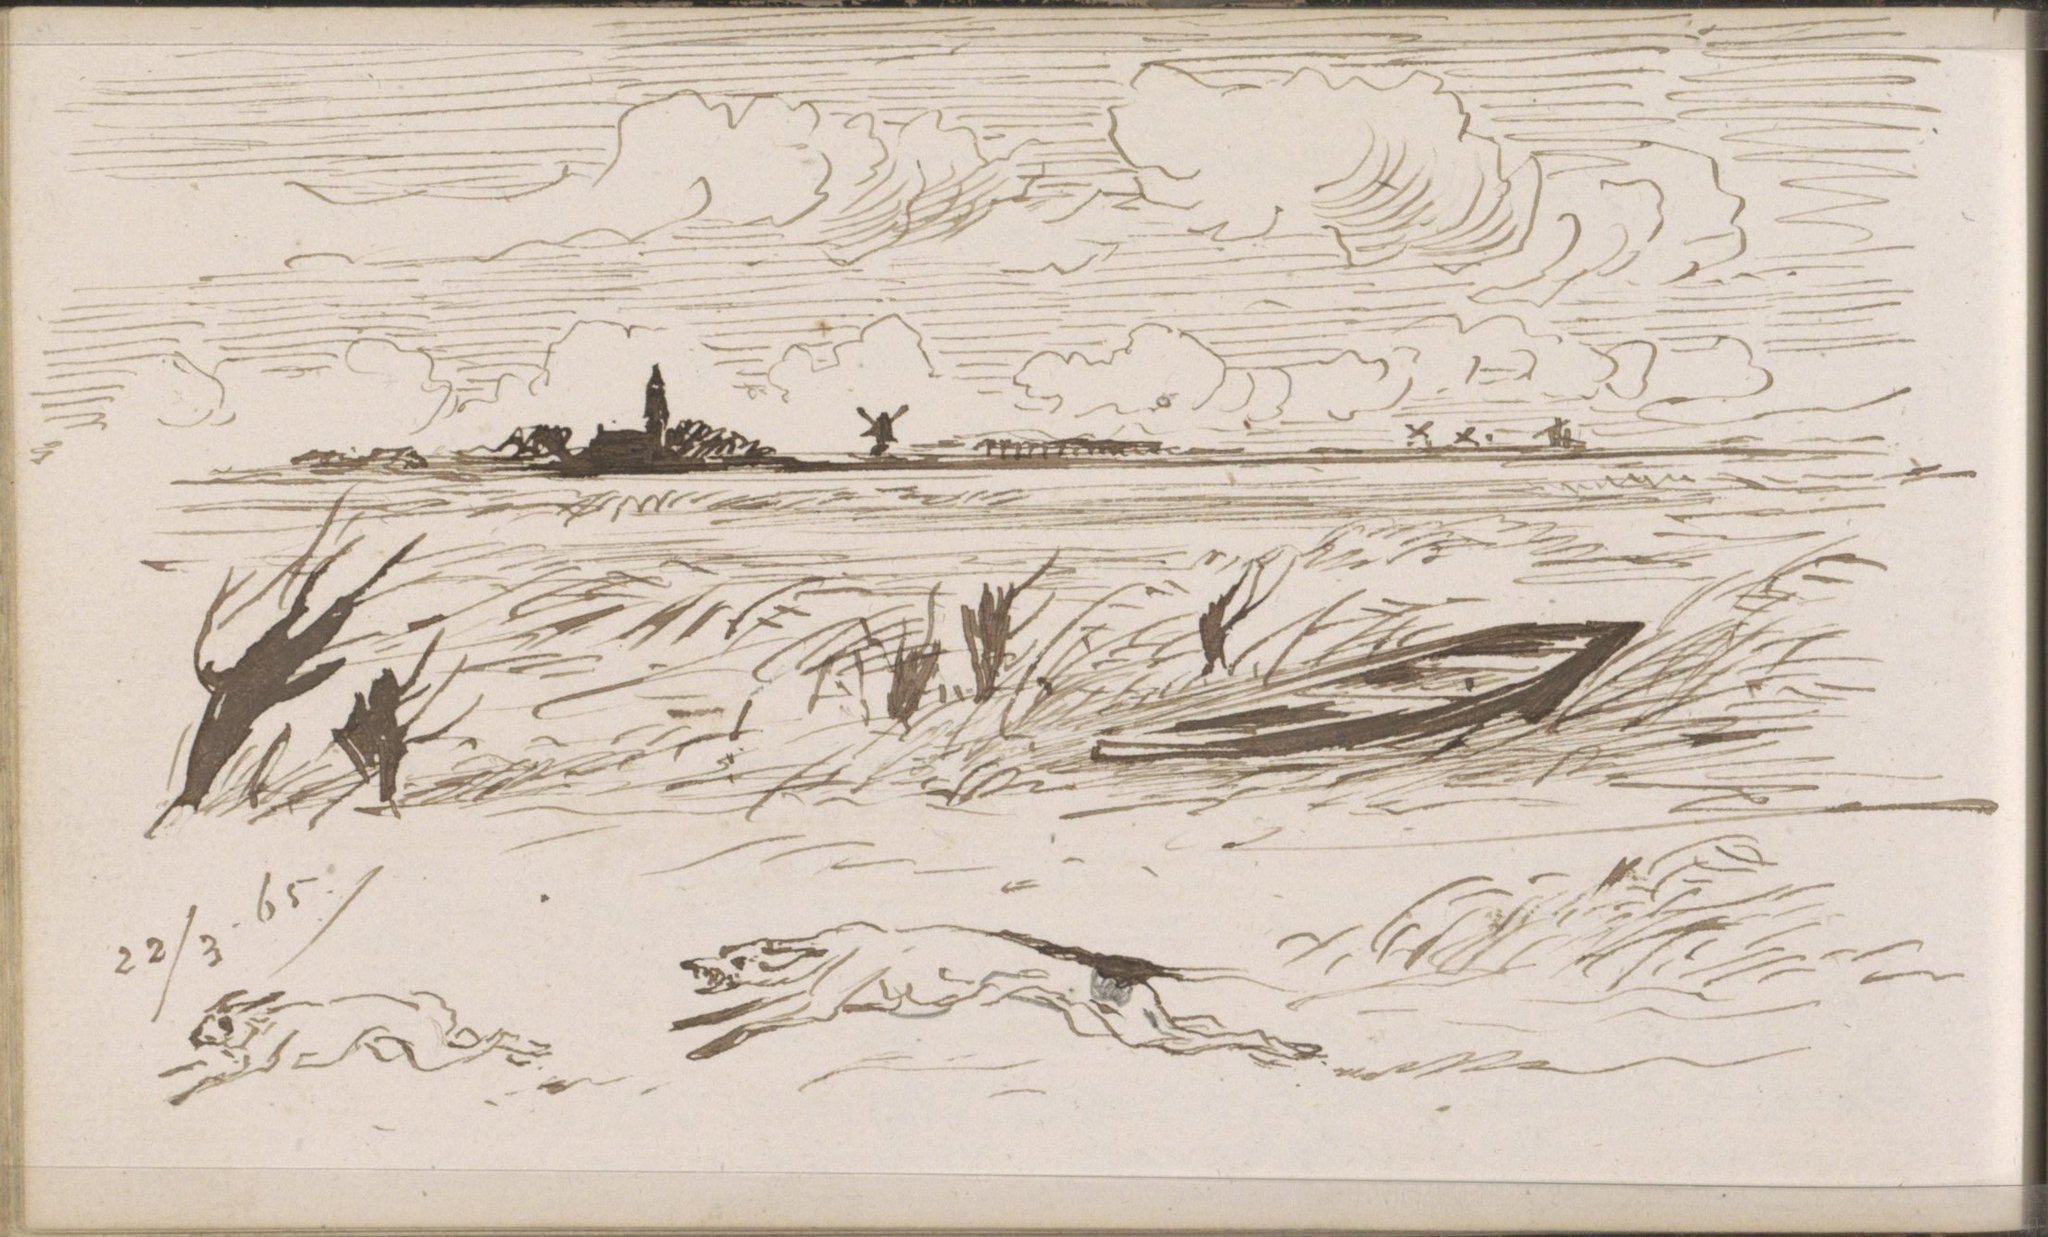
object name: sketchbook leaf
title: Rivierlandschap met een kerktoren en molens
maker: johannes tavenraat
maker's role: draughtsman, painter, print maker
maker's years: 1809-1881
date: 1803-1865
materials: ink, paper, pencil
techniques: pen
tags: city-view, and landscape with man-made constructions, rodents: hare, landscapes with waters, waterscapes, seascapes (in the temperate zone), rowing-boat, canoe, etc., windmill in landscape, dog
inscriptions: date: ‘22/3 65’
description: Aan de oever van de rivier ligt een sloep. Tevens een studie van een hond die een haas achterna zit. Blad 62 verso uit een schetsboek met 98 bladen.